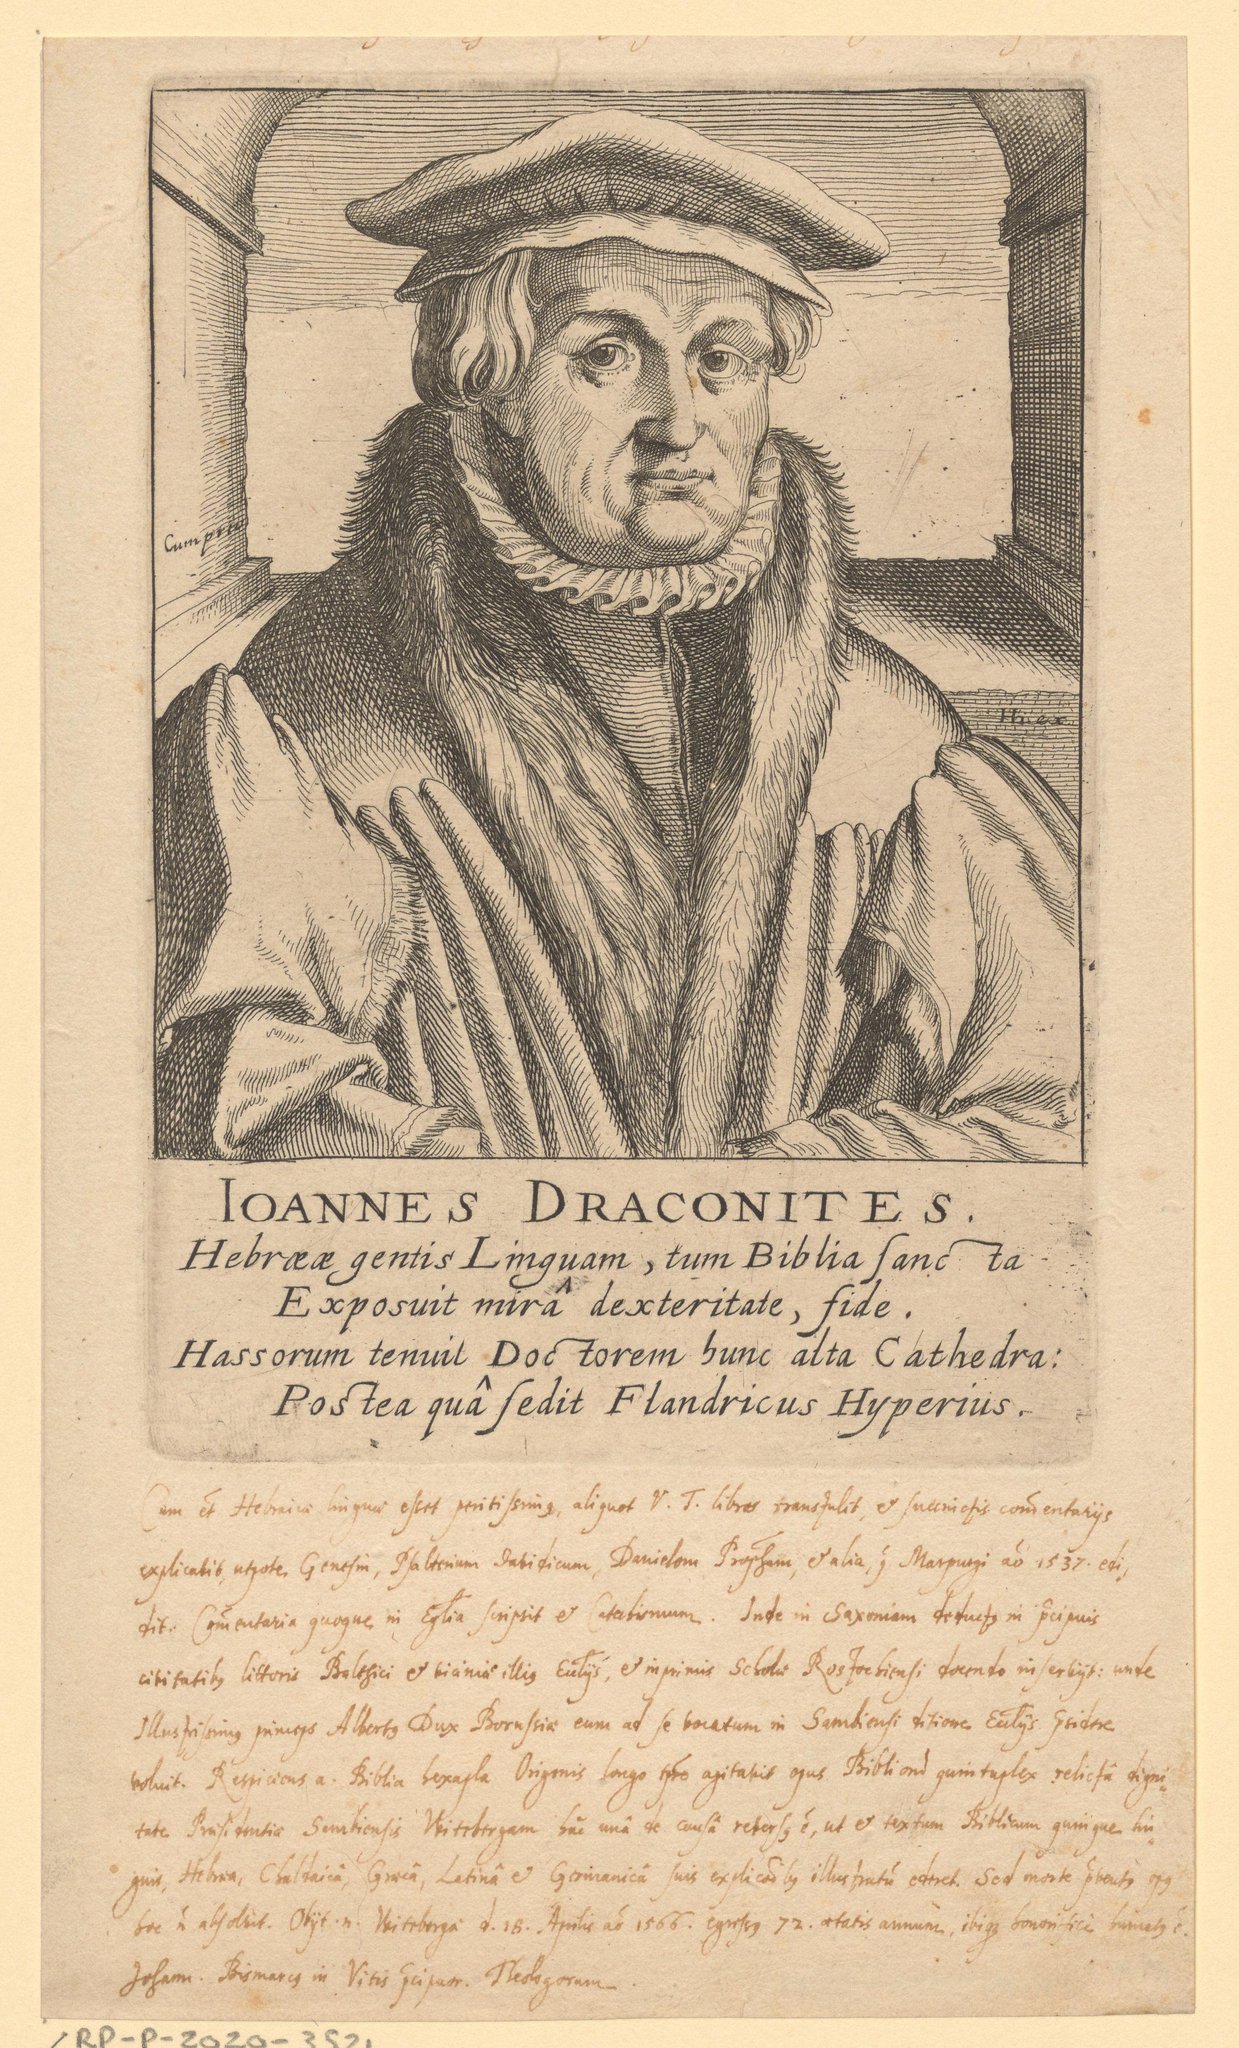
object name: print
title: Portret van Johann Draconites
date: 1583-1650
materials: paper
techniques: etching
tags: theologian, historical persons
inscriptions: inscription: ‘Cum et Hebrai[...] lingui (...)’